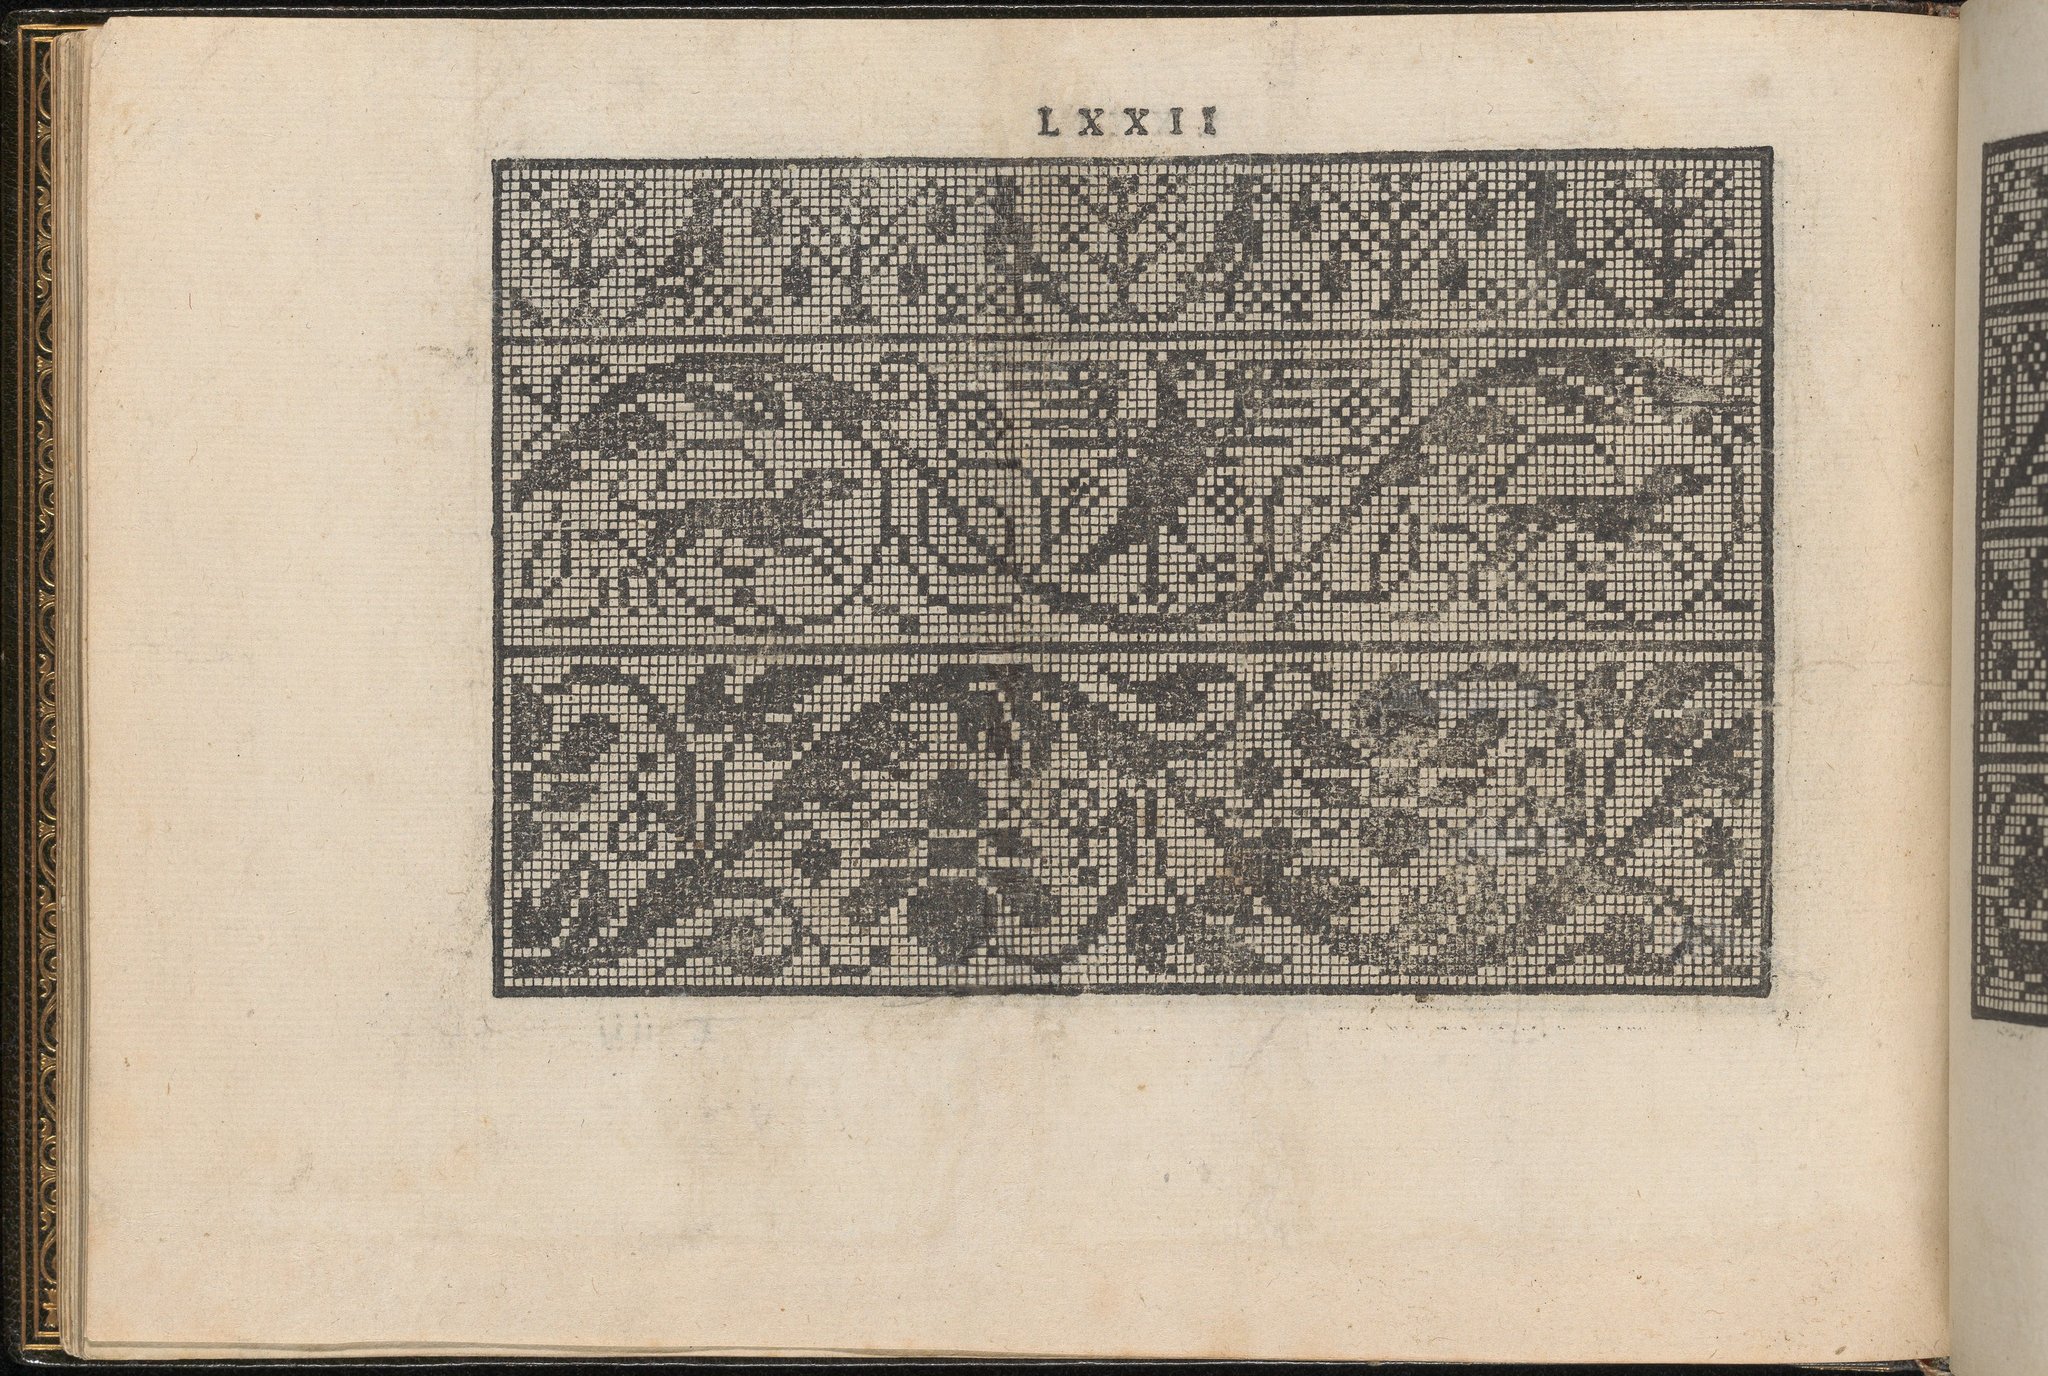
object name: book print ornament architecture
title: La Vera Perfettione del Disegno di varie sorti di recami, page 36 (verso)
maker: giovanni ostaus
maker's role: publisher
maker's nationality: italian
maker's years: 1507-1607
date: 1567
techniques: woodcut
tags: birds,dogs,flowers,leaves,vines